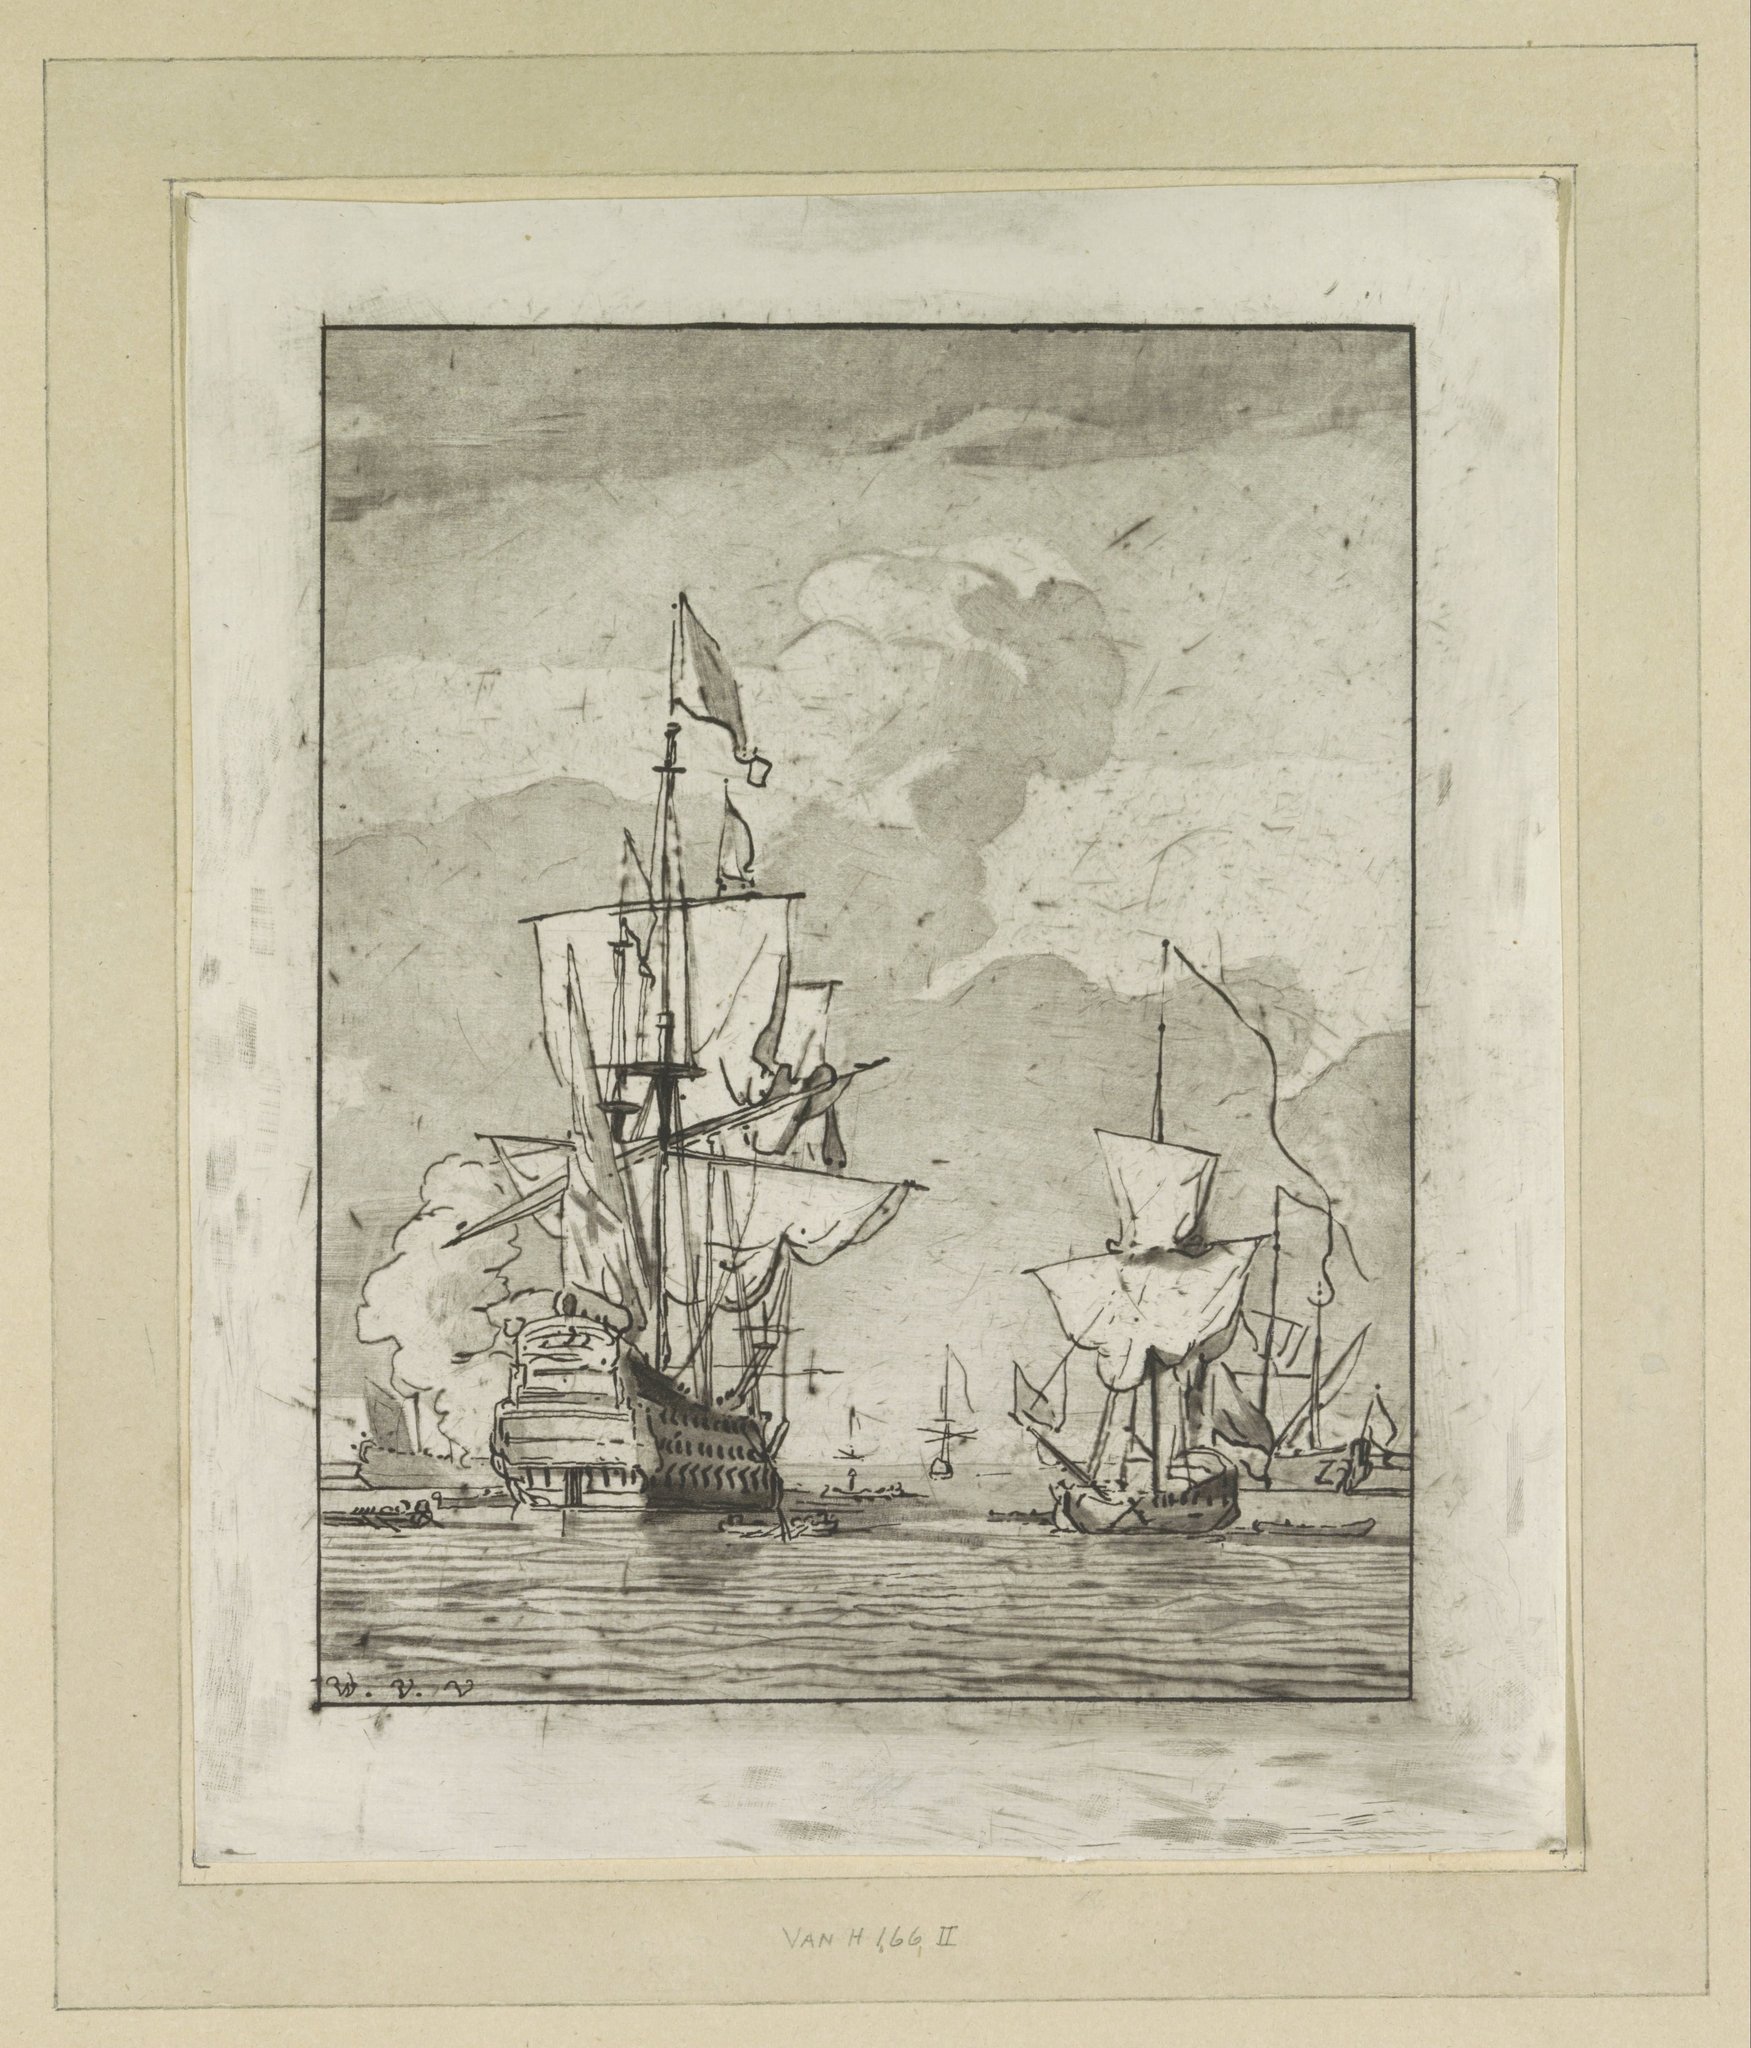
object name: print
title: Oorlogschip een schot lossend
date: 1759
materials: paper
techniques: etching, roulette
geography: amsterdam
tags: sailing-ship, sailing-boat, cannon shots (military salute)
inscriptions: collector's mark: Lugt 2228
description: Verschillende zeilschepen op zee, waarvan één een schot lost.